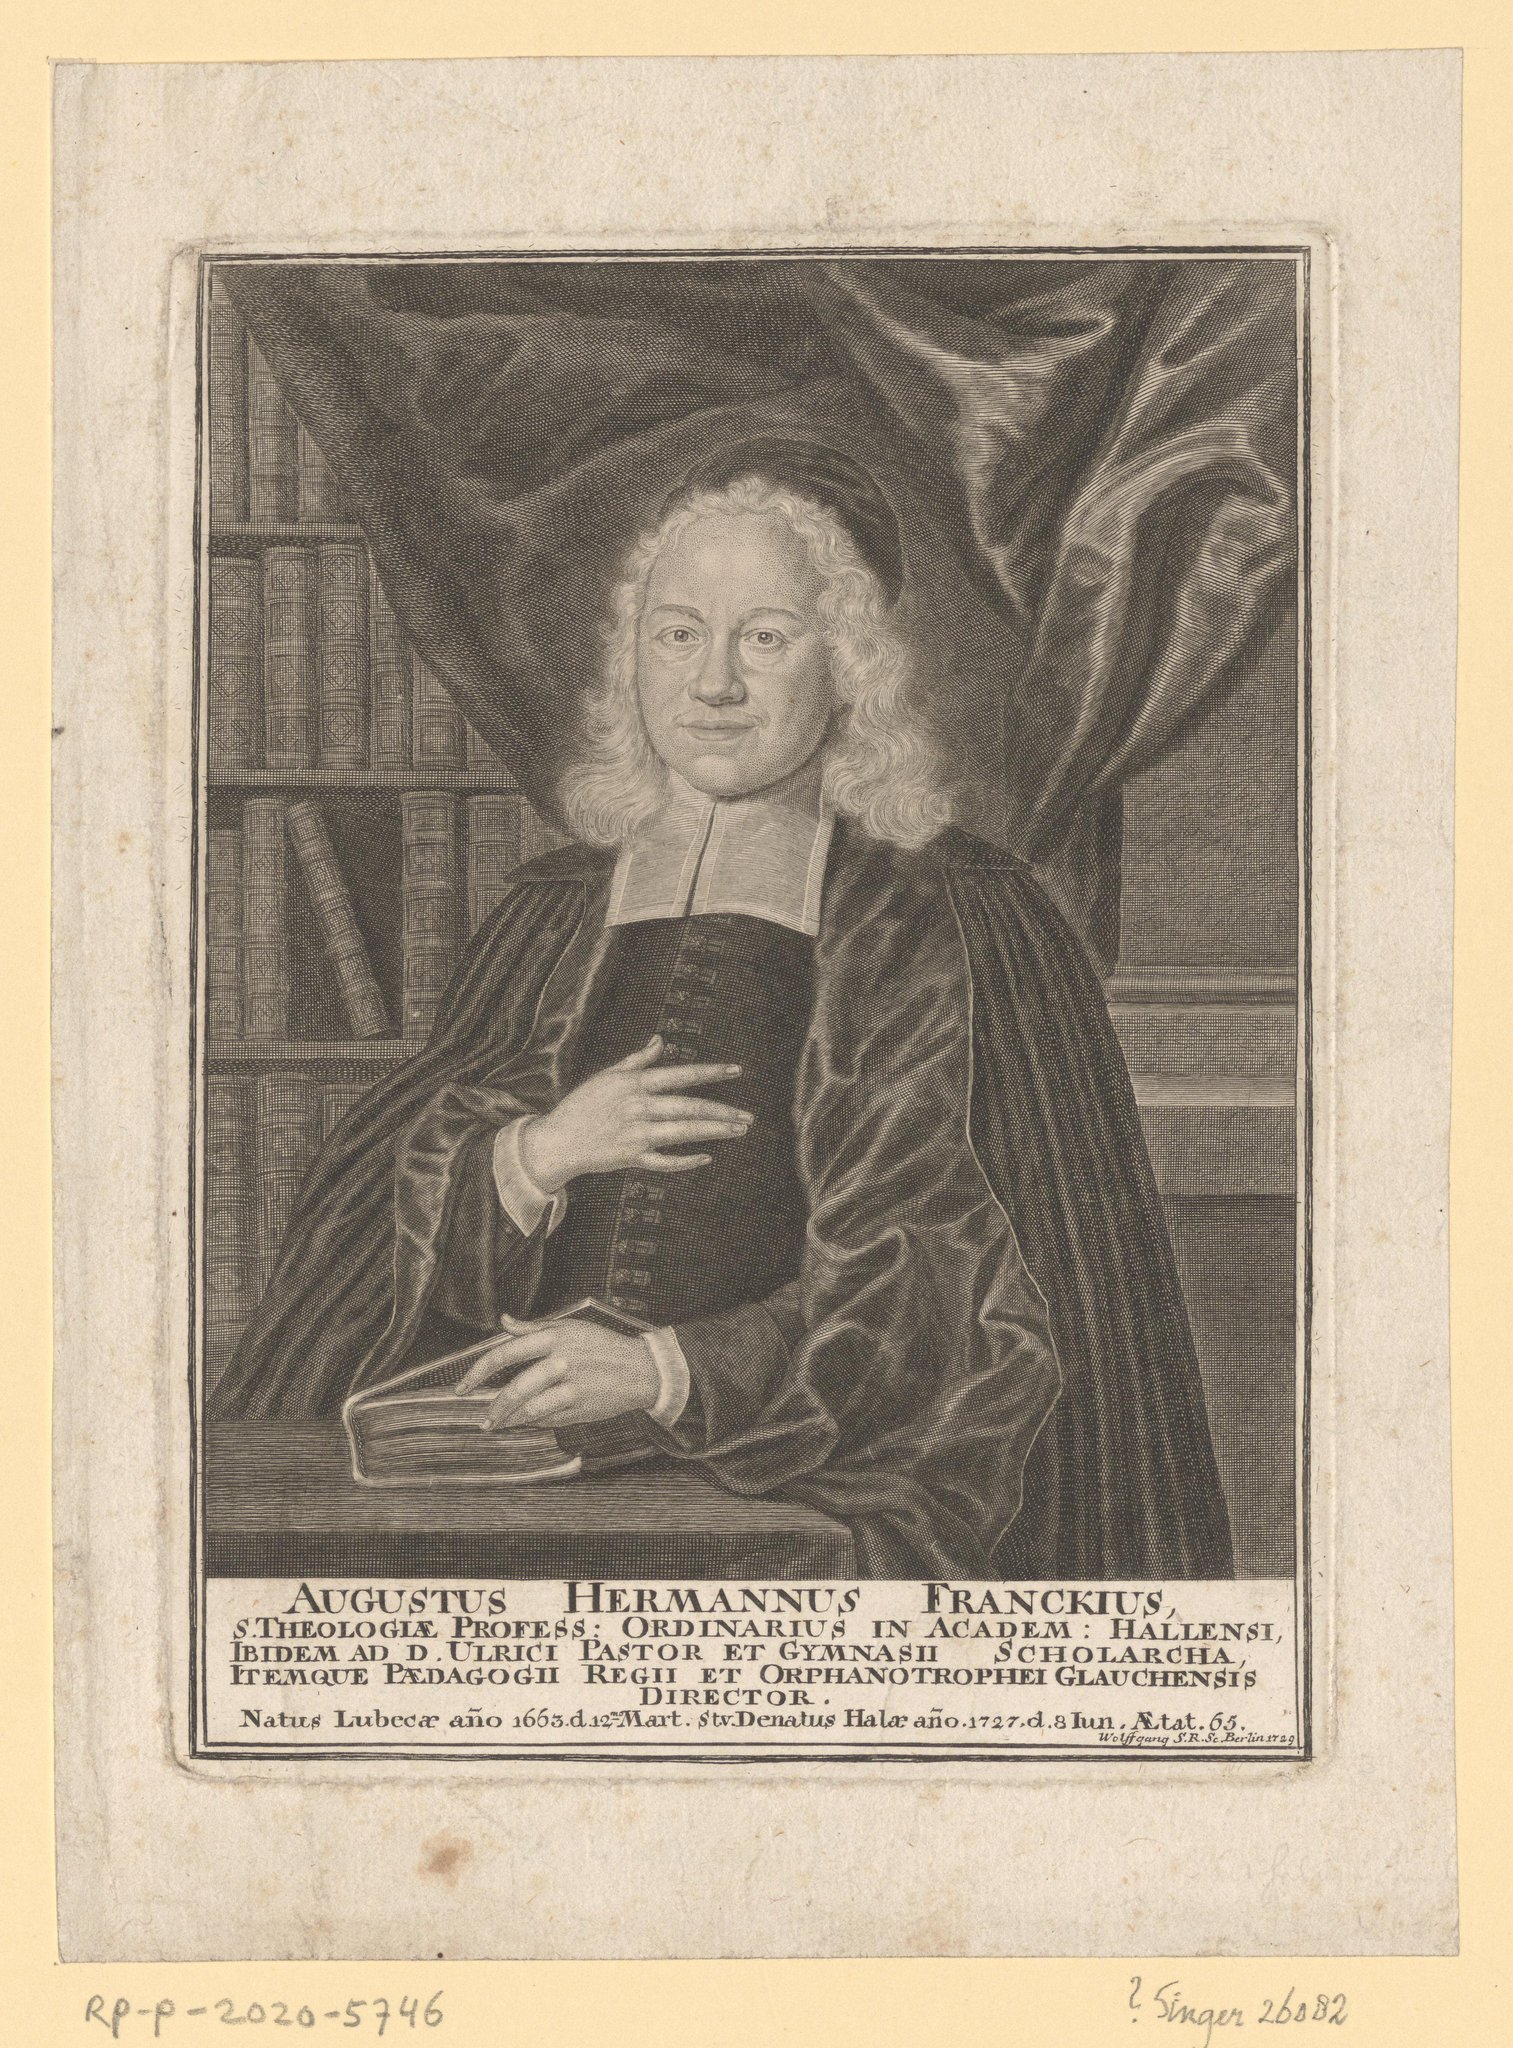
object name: print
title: Portret van Augustus Hermannus Francke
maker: johann georg wolfgang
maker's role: graveur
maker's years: 1662-1744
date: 1729-1731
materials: paper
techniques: engraving, etching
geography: berlin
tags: bookshelves, theologian, historical persons, book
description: Prent waarschijnlijk uit: Francke, August Hermann. Erklärung der Psalmen Davids. Halle: Waisenhausdruckerei, 1730, dl. 1. Of uit het tweede deel uit 1731.